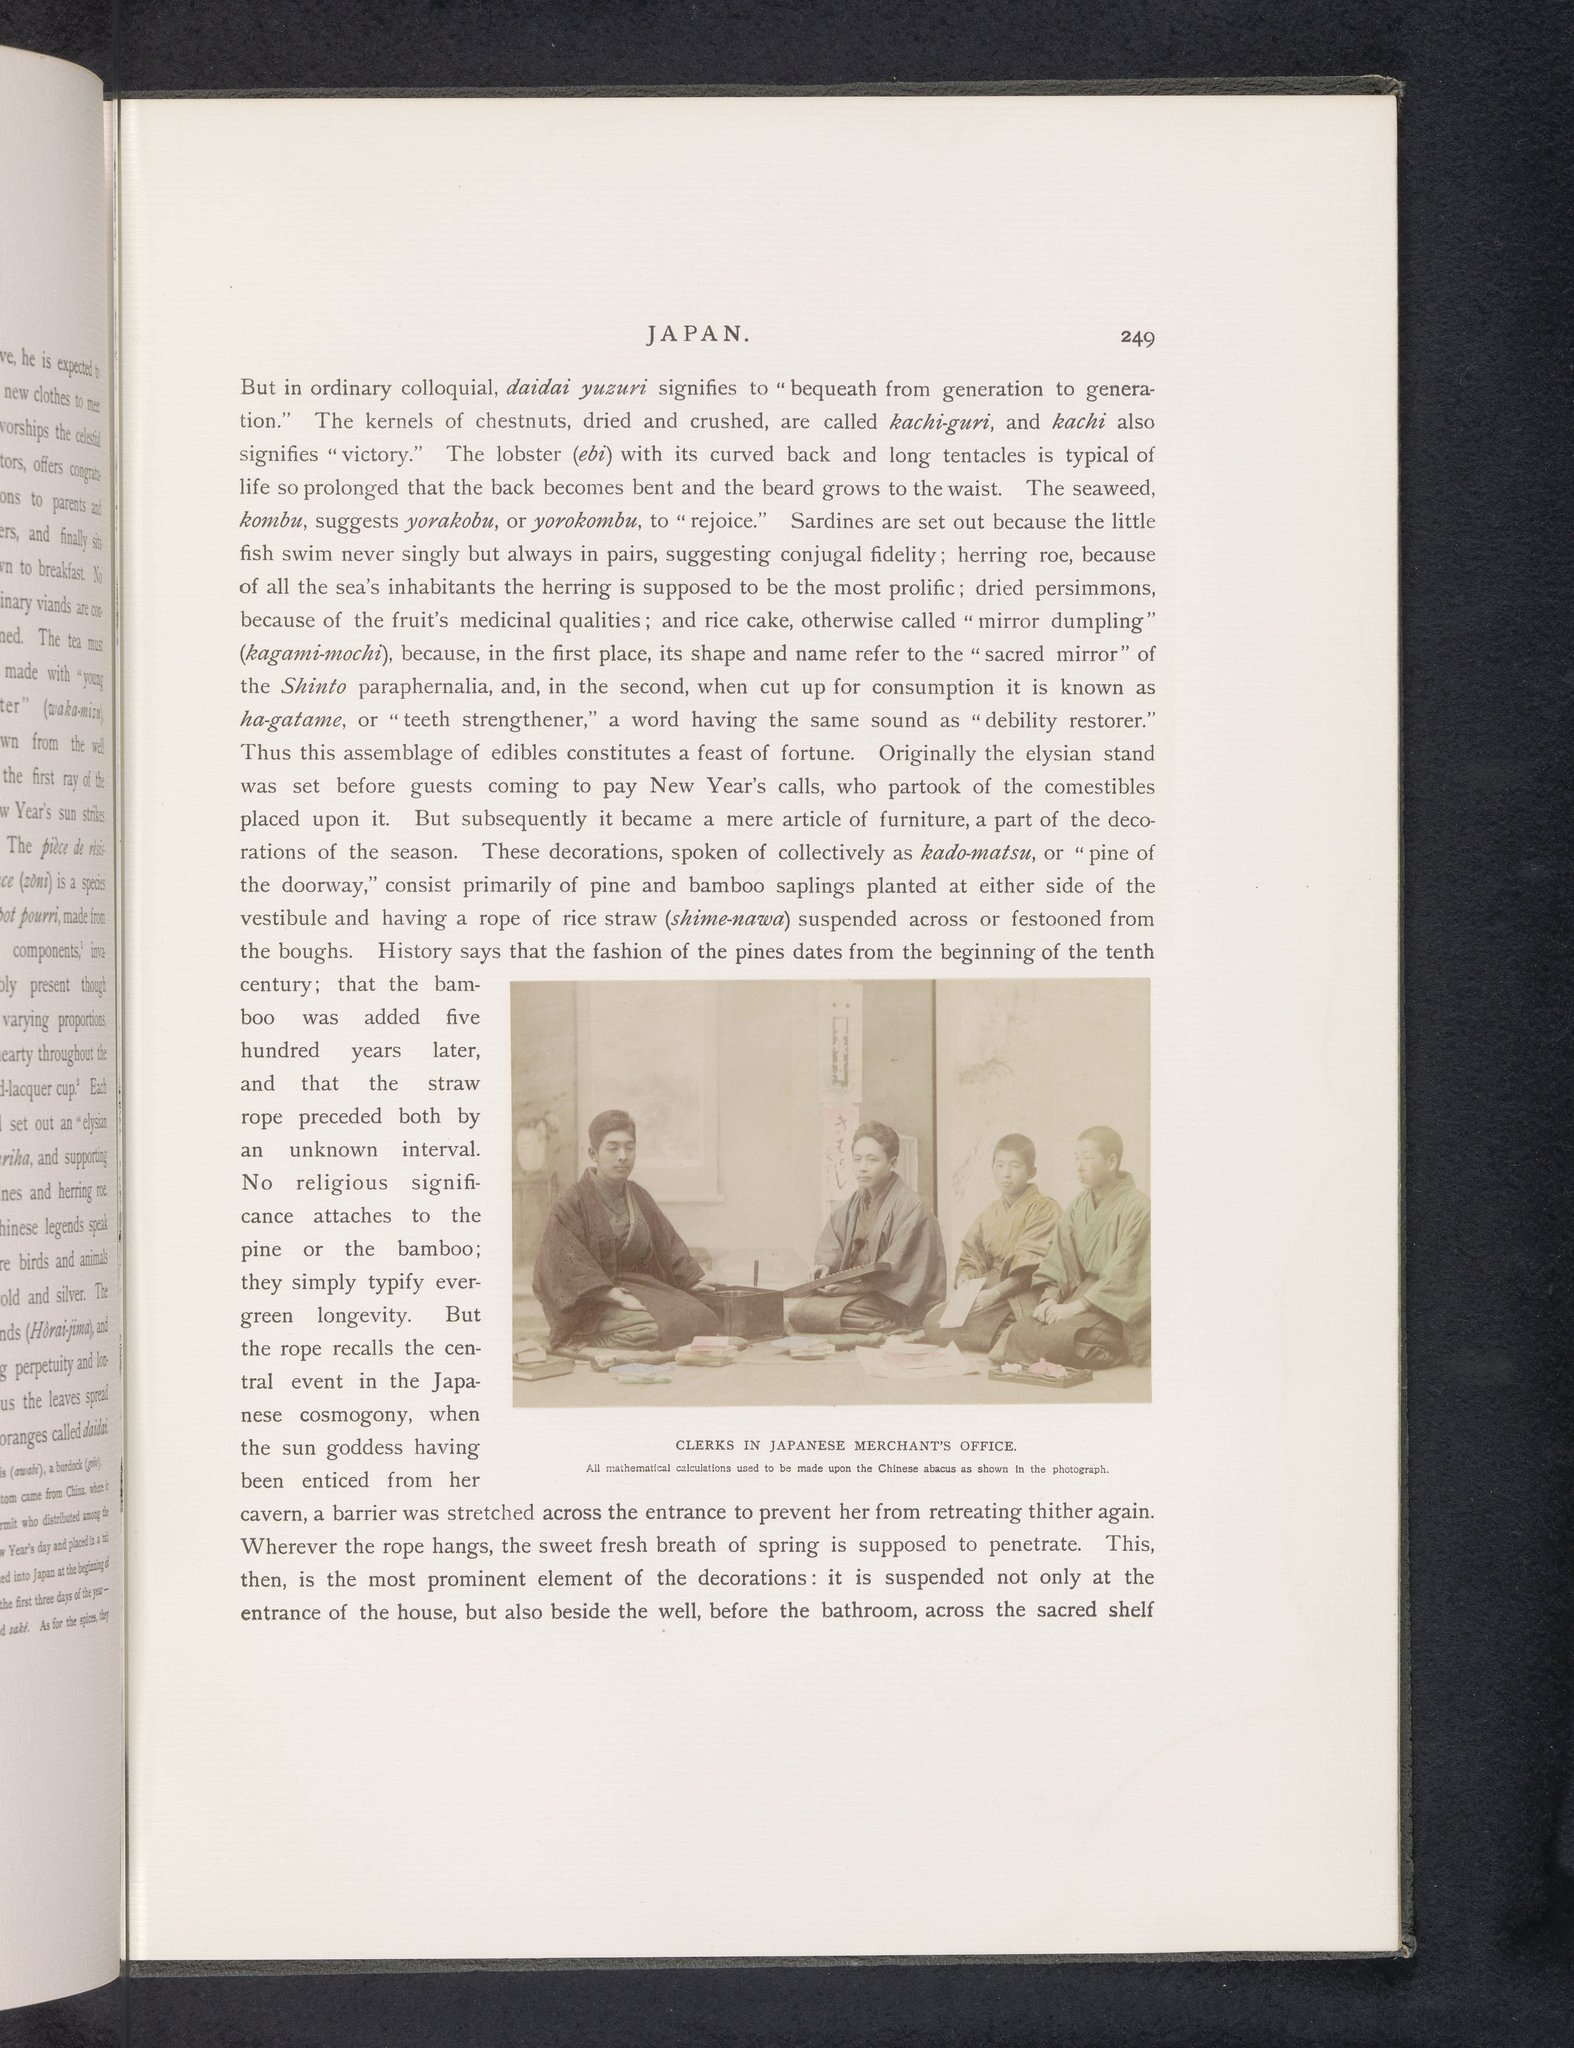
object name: page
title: Clerks in Japanese merchant's office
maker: Anonymous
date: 1887-1897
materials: photographic support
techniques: albumen print, hand coloring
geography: japan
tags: sales clerk, office (~ administration)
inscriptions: inscription: ‘All mathematical calculations used to be made upon the Chinese abacus as shown in the photograph.’